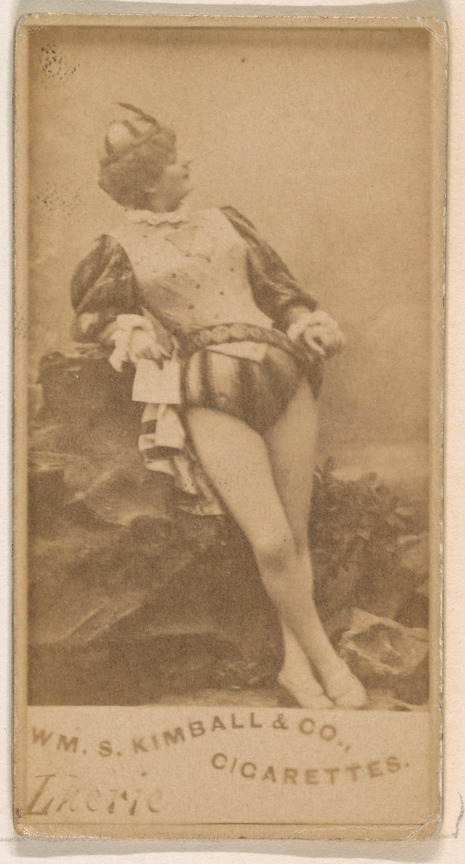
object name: photograph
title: Miss Lherie, from the Actresses series (N203) issued by Wm. S. Kimball & Co.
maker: william s. kimball & company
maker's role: publisher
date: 1889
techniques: color lithograph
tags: profiles,women,actresses